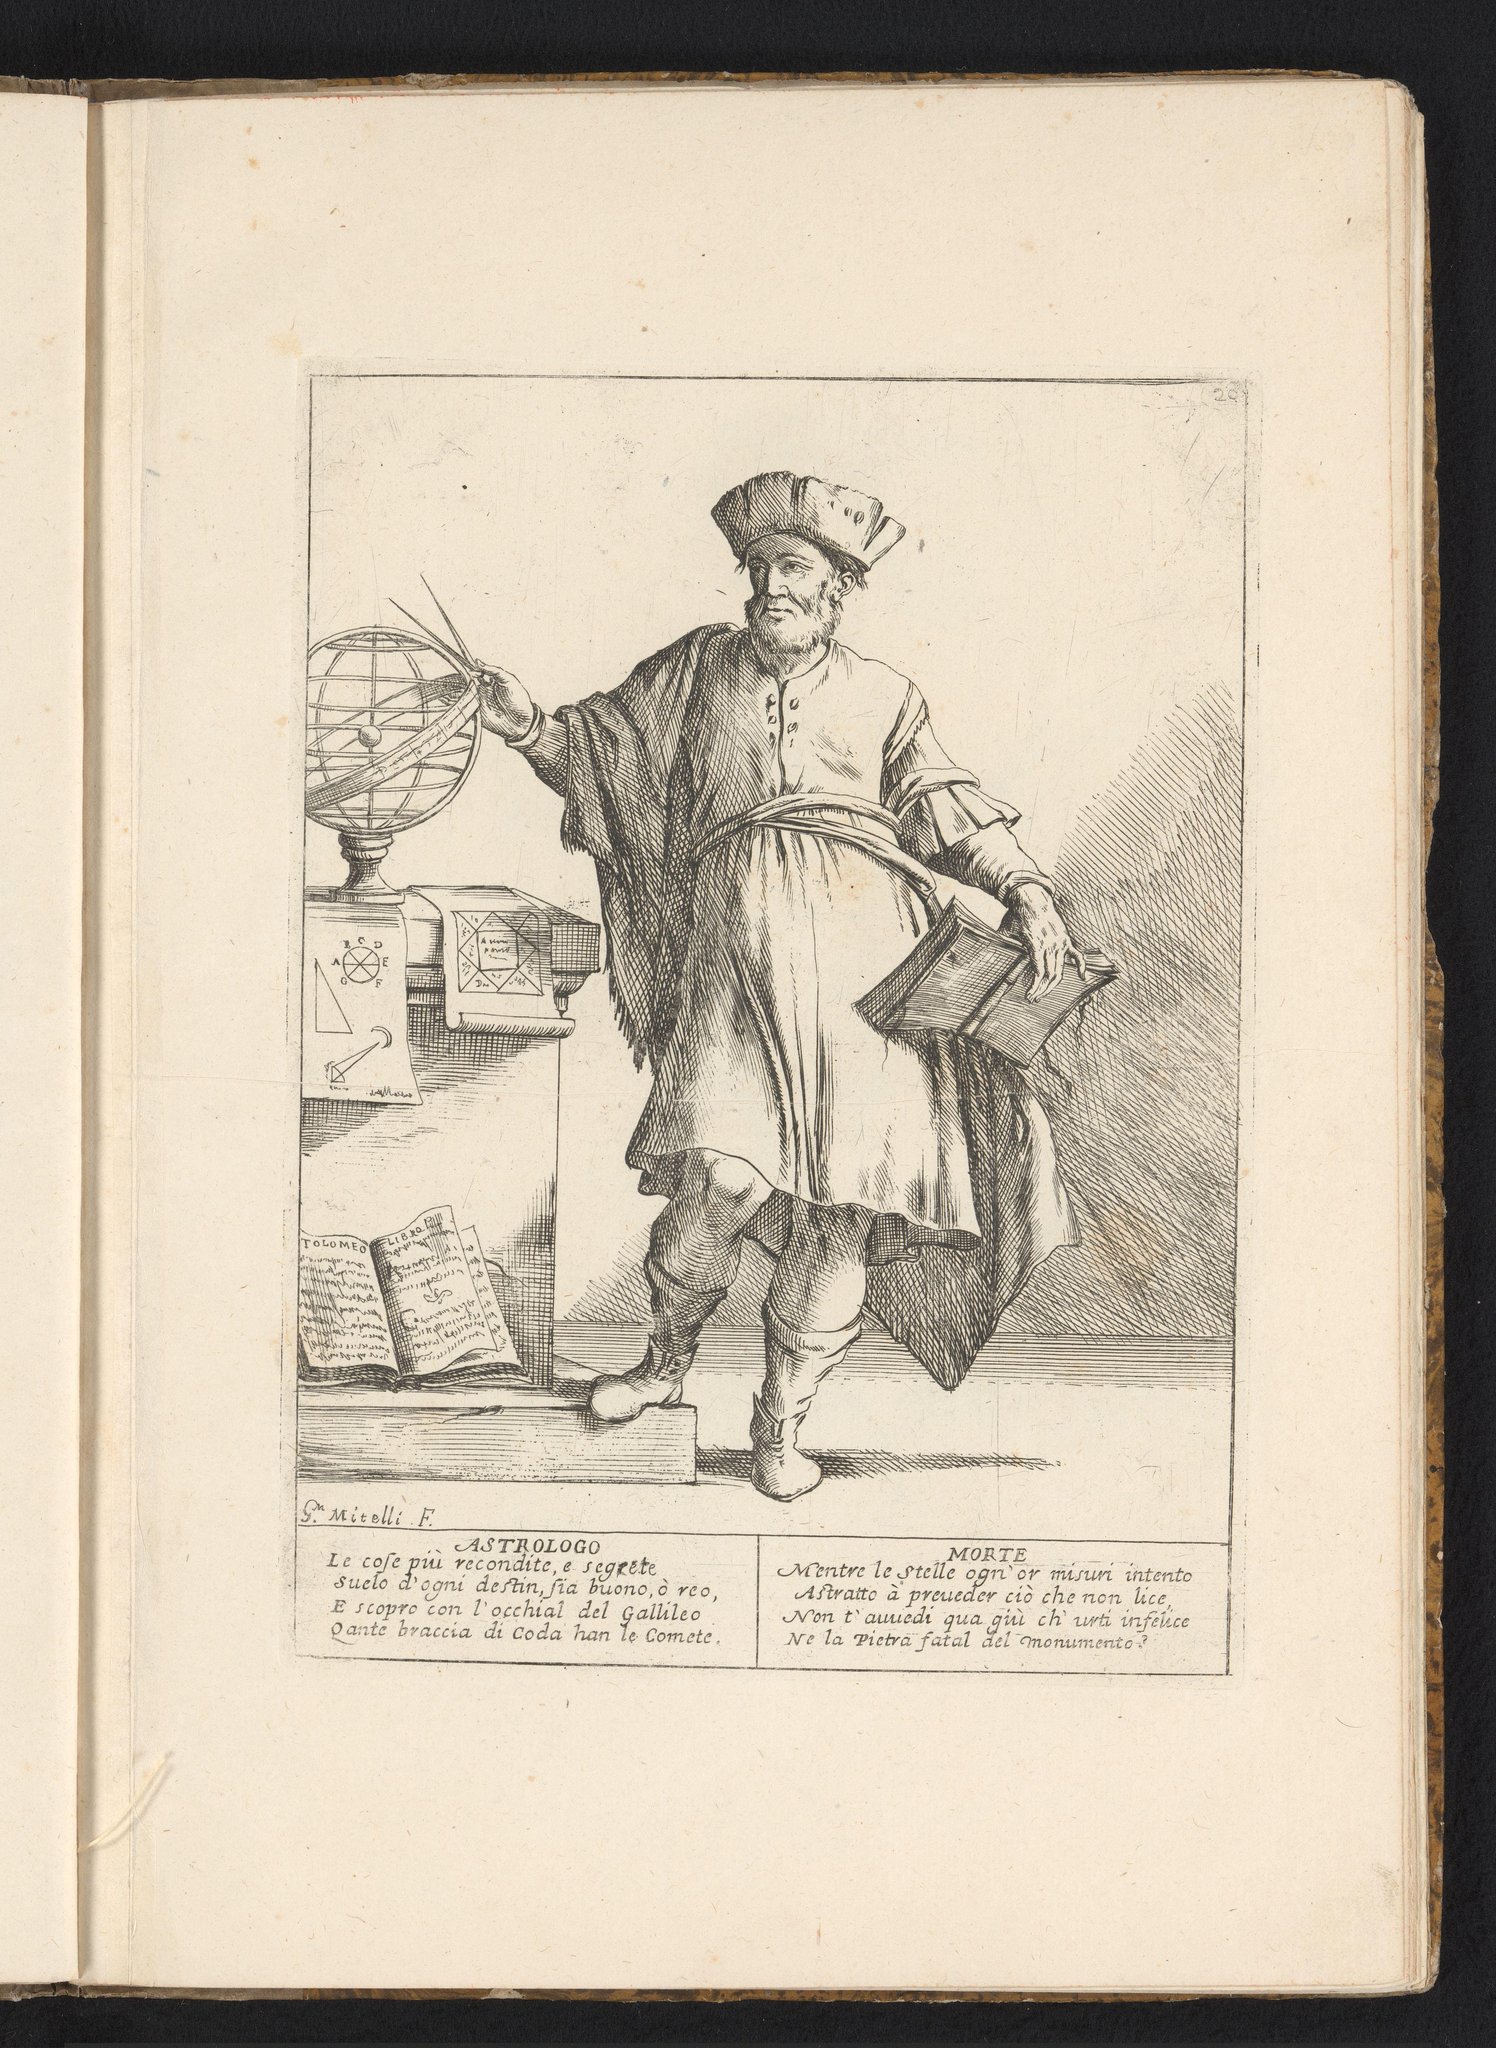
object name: print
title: De astroloog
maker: giuseppe maria mitelli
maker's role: draughtsman, painter, print maker, publisher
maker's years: 1634-1718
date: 1675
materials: paper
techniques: engraving, etching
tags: horoscope, scenes symbolizing 'vanitas', the 24 hours of day and night, astrologer at work, armillary sphere, skeleton celestial globe, personifications ~ the life of man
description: Een astroloog (Astrologo) staande naast een armillarium, passer in de hand, omringd door boeken en paperassen (o.a. een geboortehoroscoop en een boek van Ptolomeus). Met twee vierregelige verzen in het Italiaans. Genummerd rechtsboven: 20. Onderdeel van de serie 'De vierentwintig uren van het menselijk geluk'.